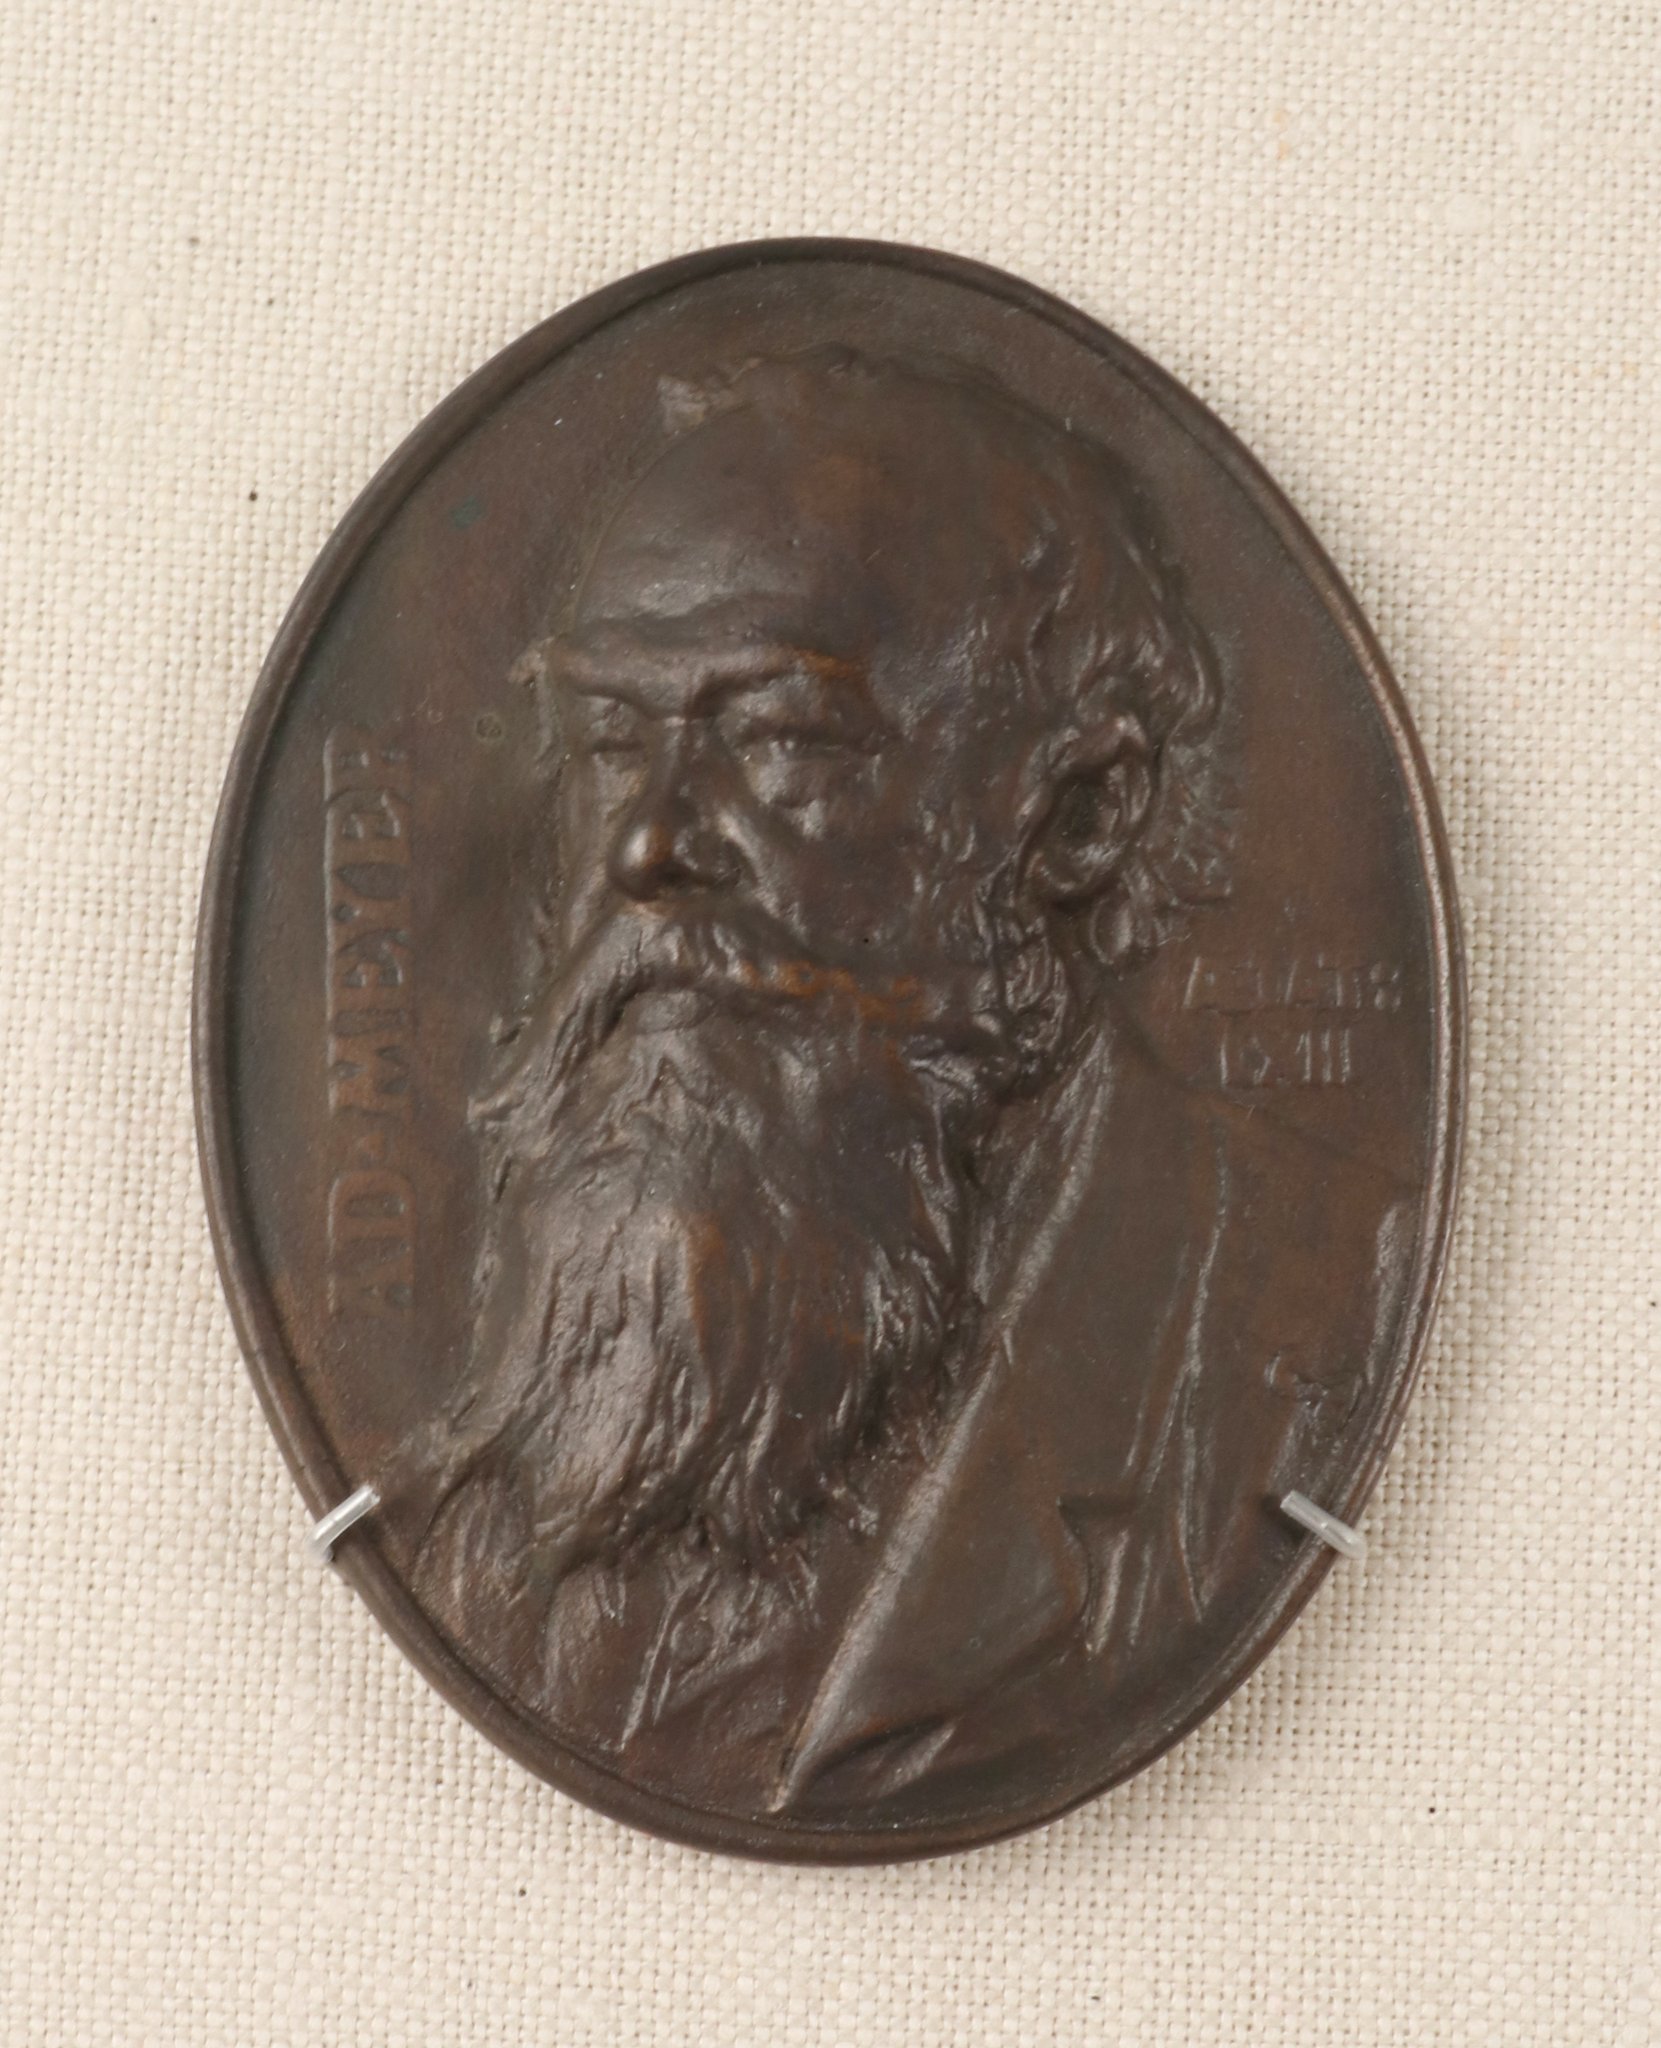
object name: medallion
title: Portrait of Adolf Meyer-Gedanensis, Numismatist, in his 63rd Year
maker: anton scharff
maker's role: artist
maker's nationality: austrian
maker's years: 1845-1903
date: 1889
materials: bronze